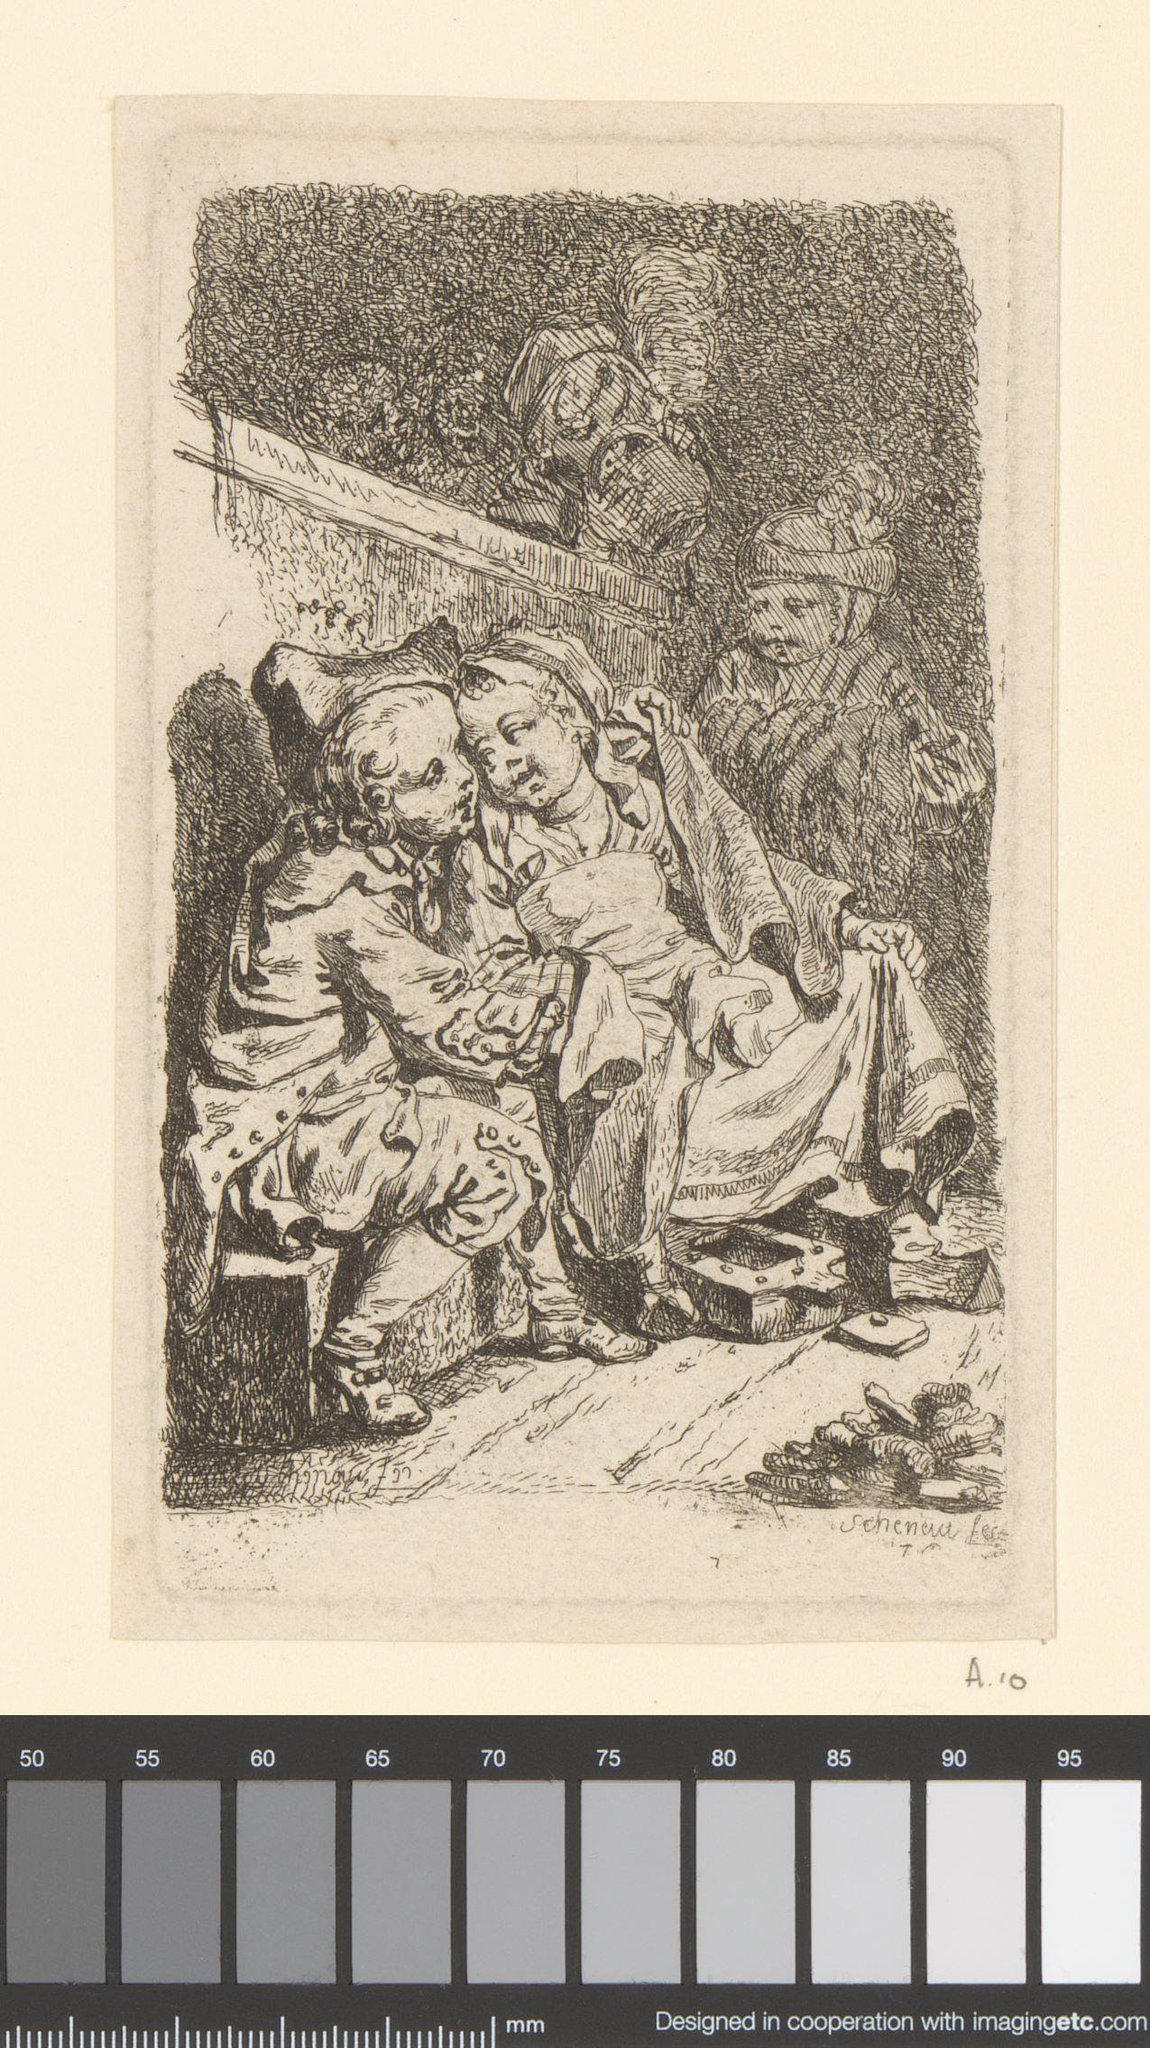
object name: print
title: Jongen met zijn handen onder de rok van een meisje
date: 1765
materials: paper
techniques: etching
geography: paris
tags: relations between the sexes, childhood (alleg.)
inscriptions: collector's mark: Lugt 2228